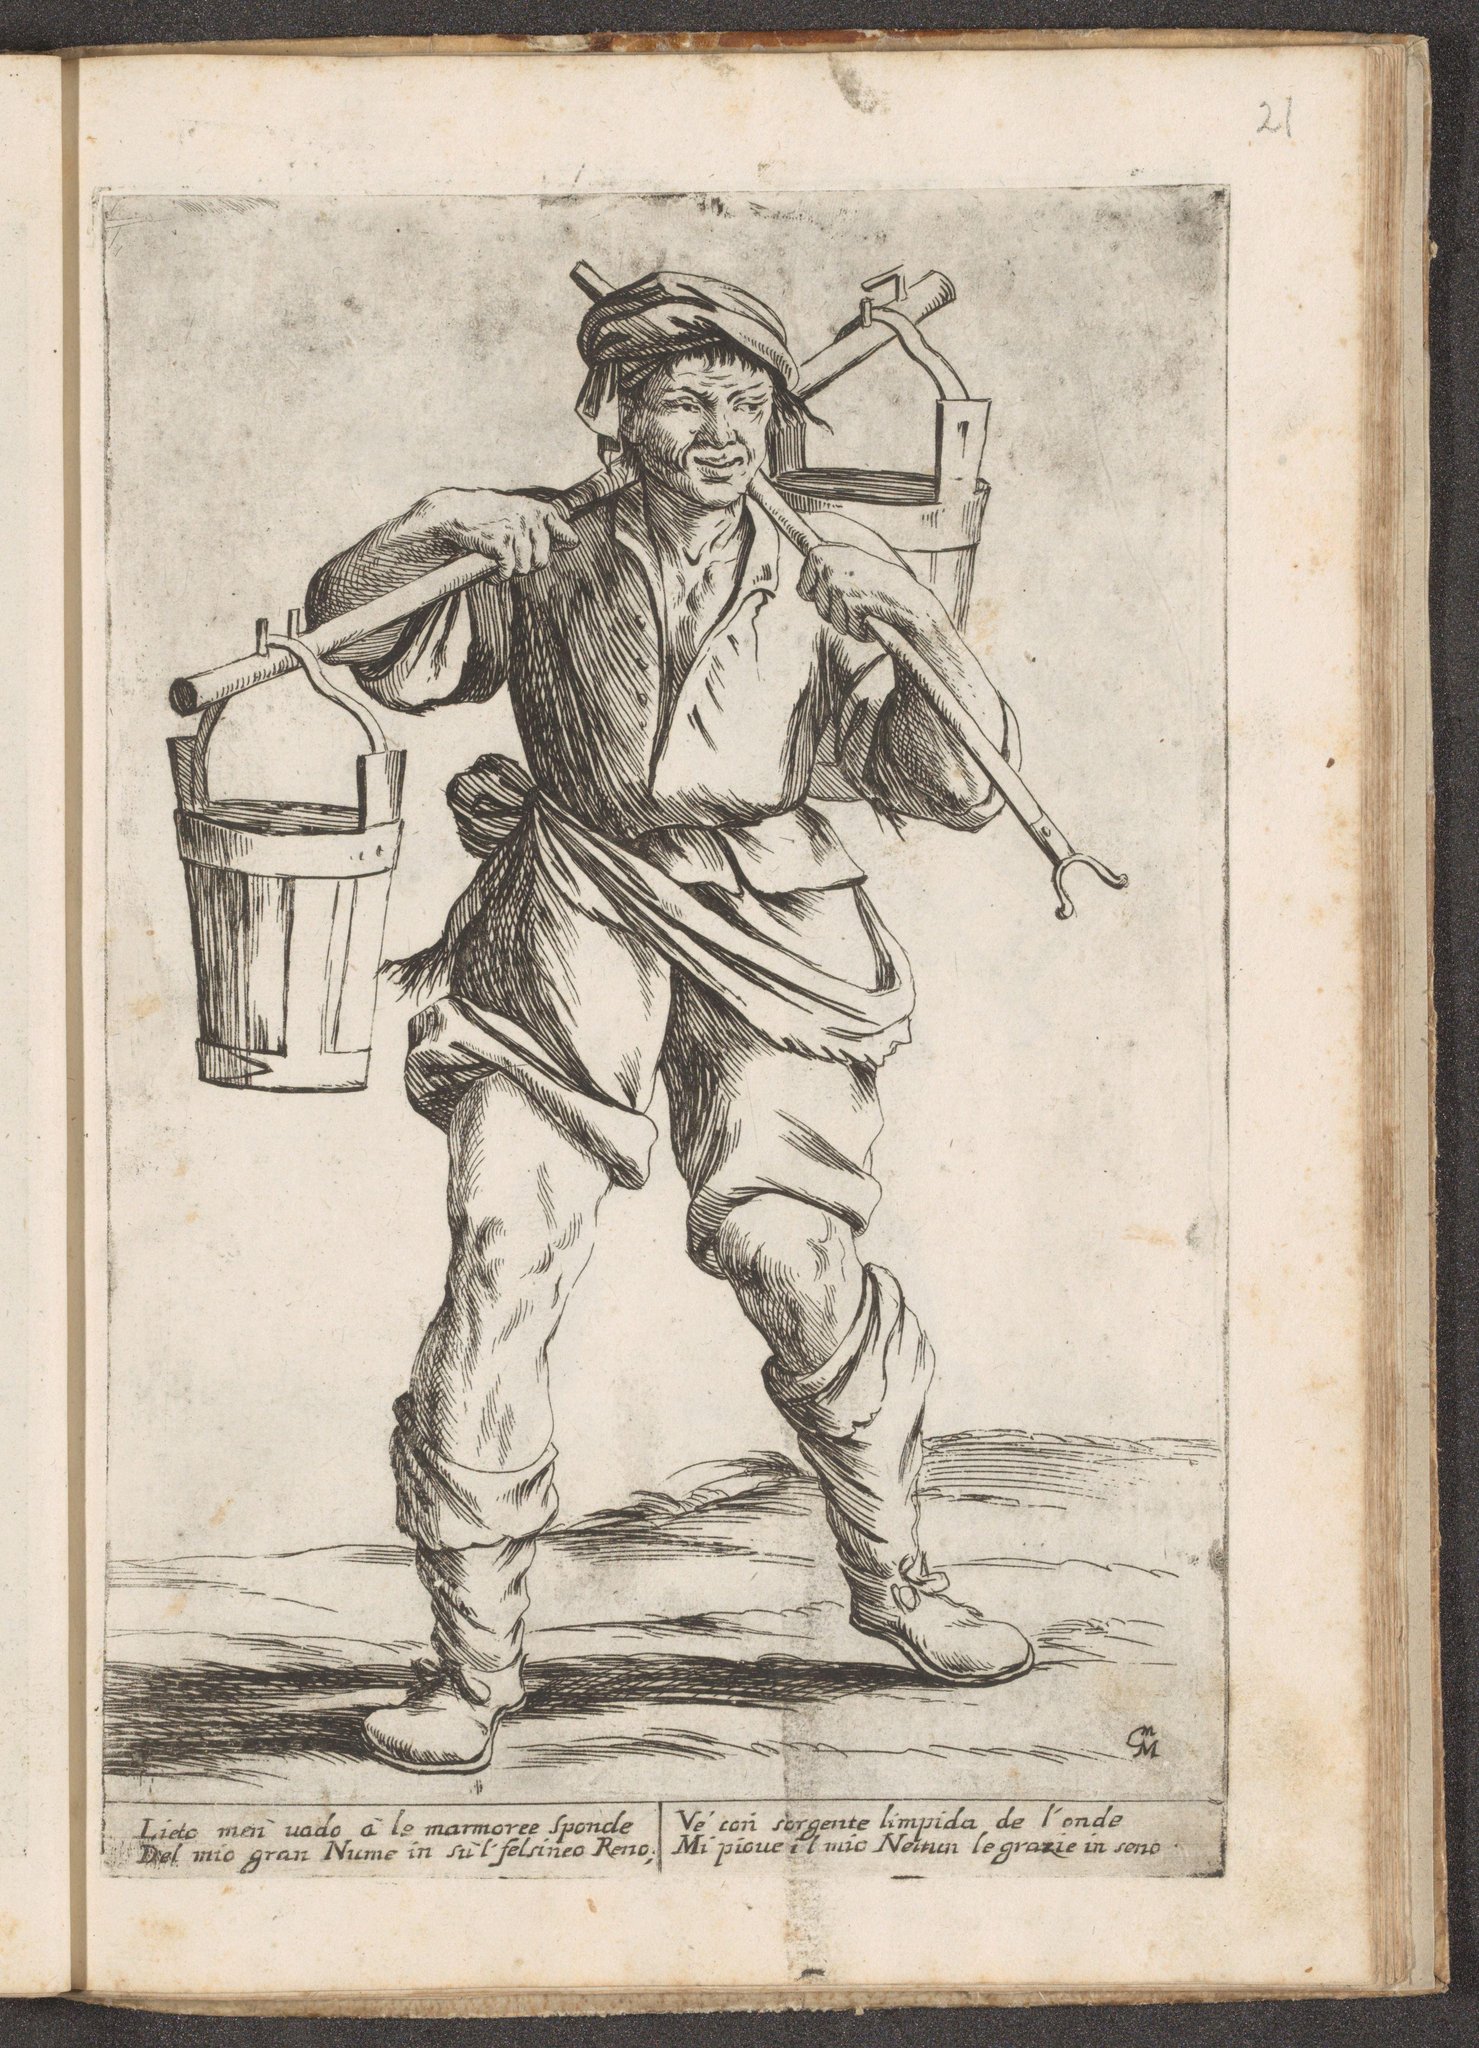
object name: album leaf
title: Waterdrager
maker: giuseppe maria mitelli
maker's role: draughtsman, painter, print maker, publisher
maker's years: 1634-1718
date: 1660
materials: paper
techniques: etching, intaglio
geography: bologna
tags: wooden container: barrel, cask, bucket, street-trader, carrying something with yoke, yoke, 'cris de paris', cries of london, etc.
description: Een man met een juk met twee emmers over zijn schouder. Italiaans vers in ondermarge. De prent maakt deel uit van een album.